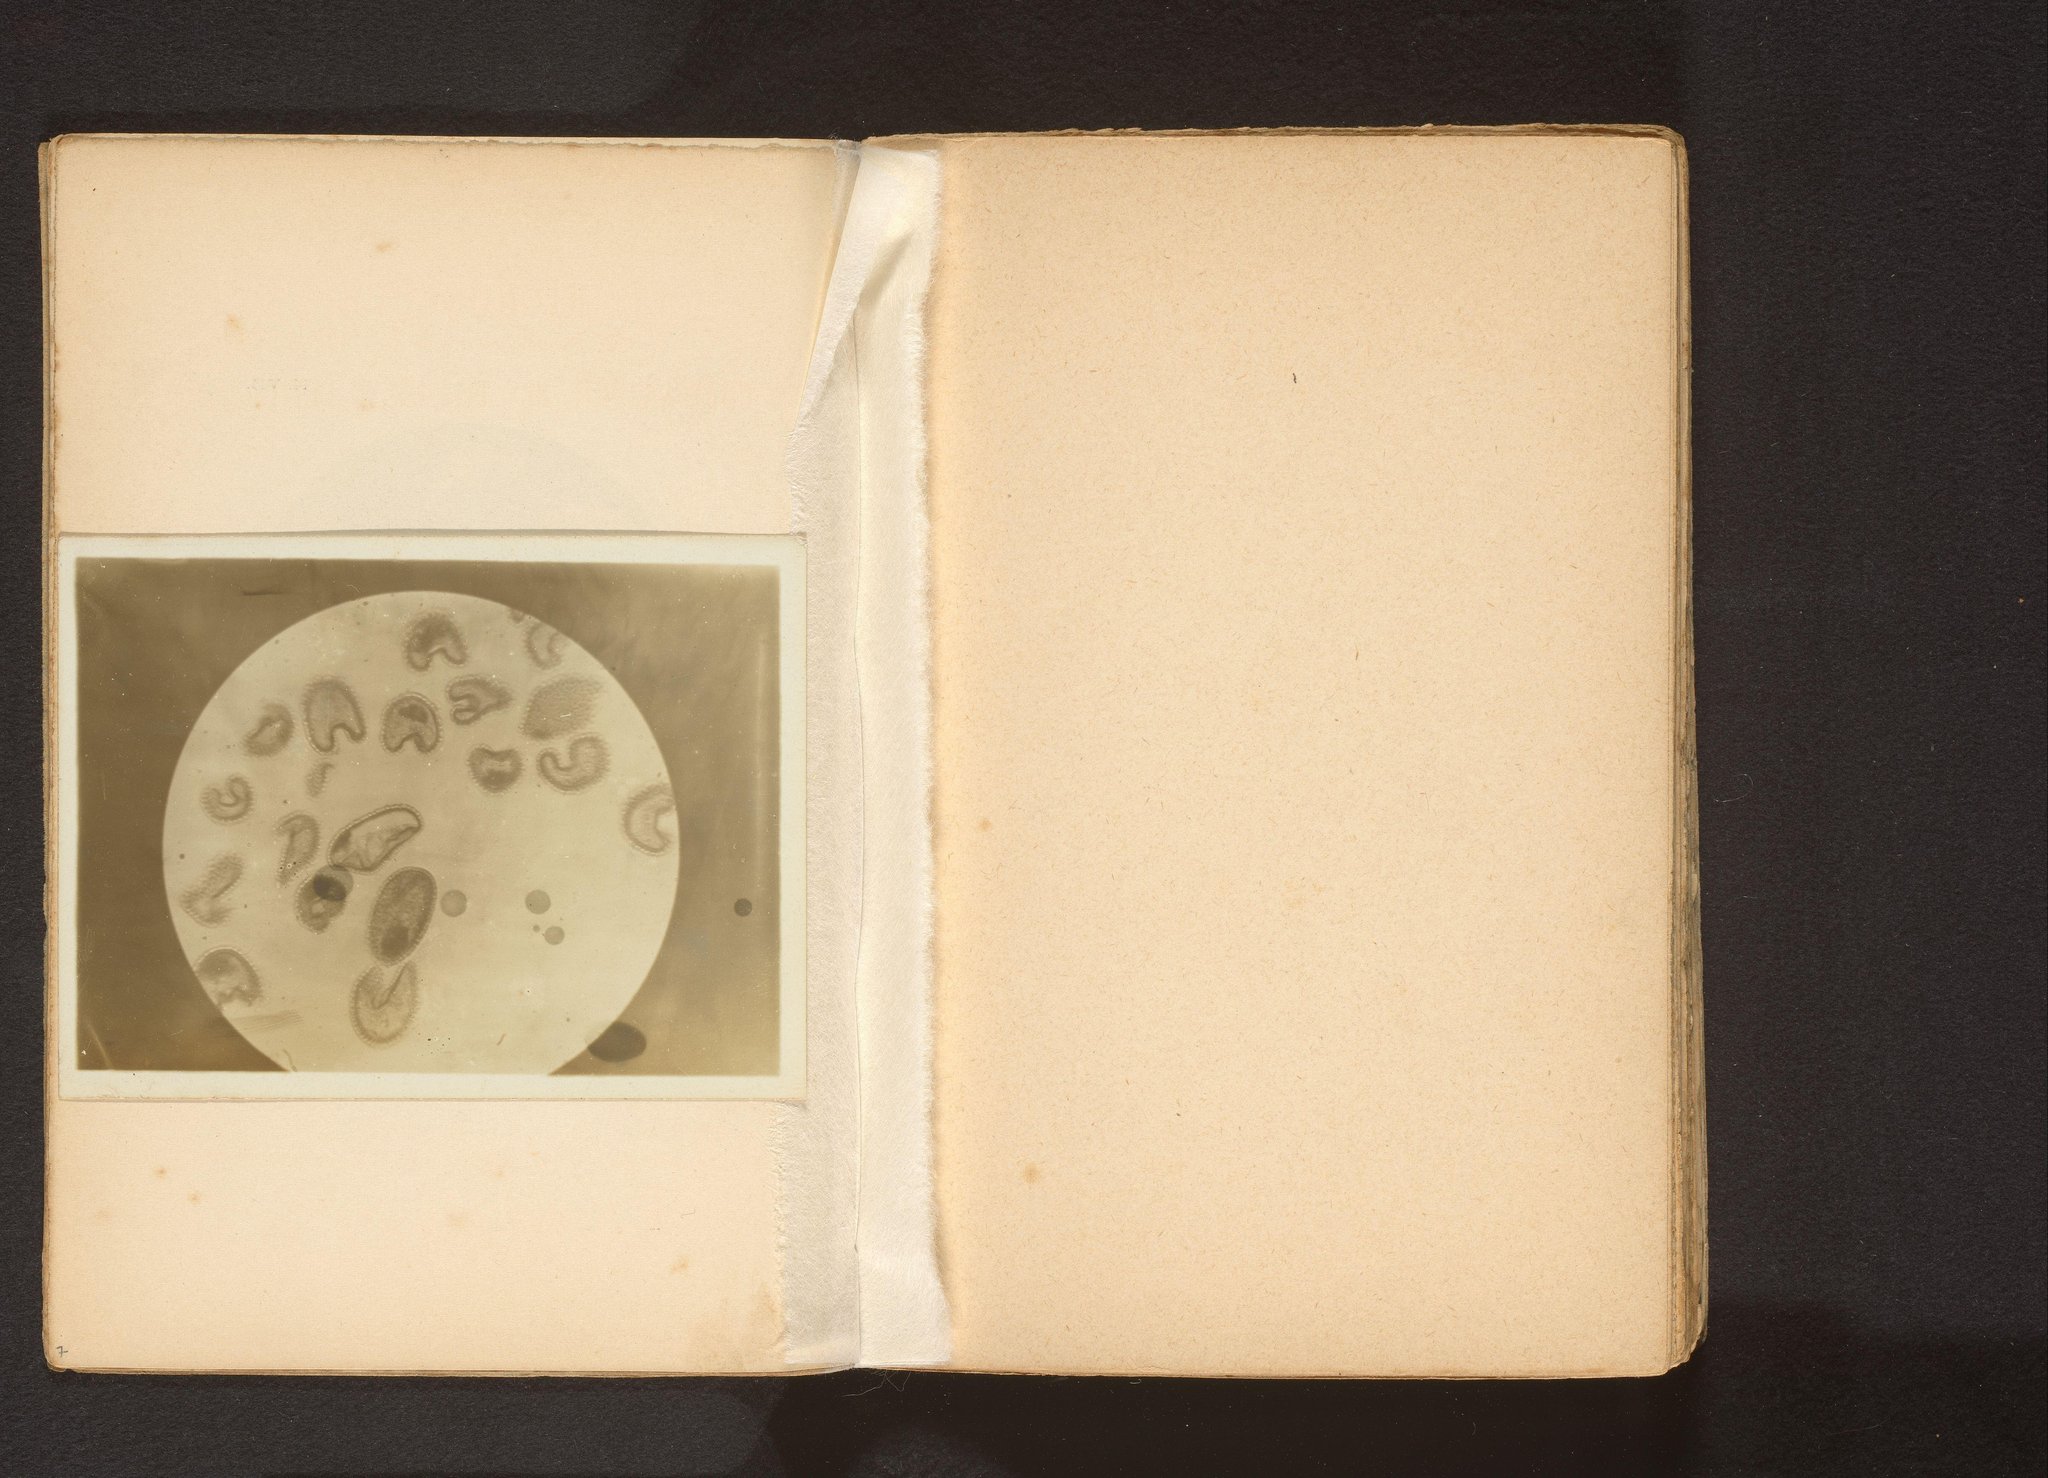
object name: page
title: Pollen de lys en formation [(...)] l'anthére (en coupe)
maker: Anonymous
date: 1880-1899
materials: photographic support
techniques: daylight paper print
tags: flowers: lily, microscope